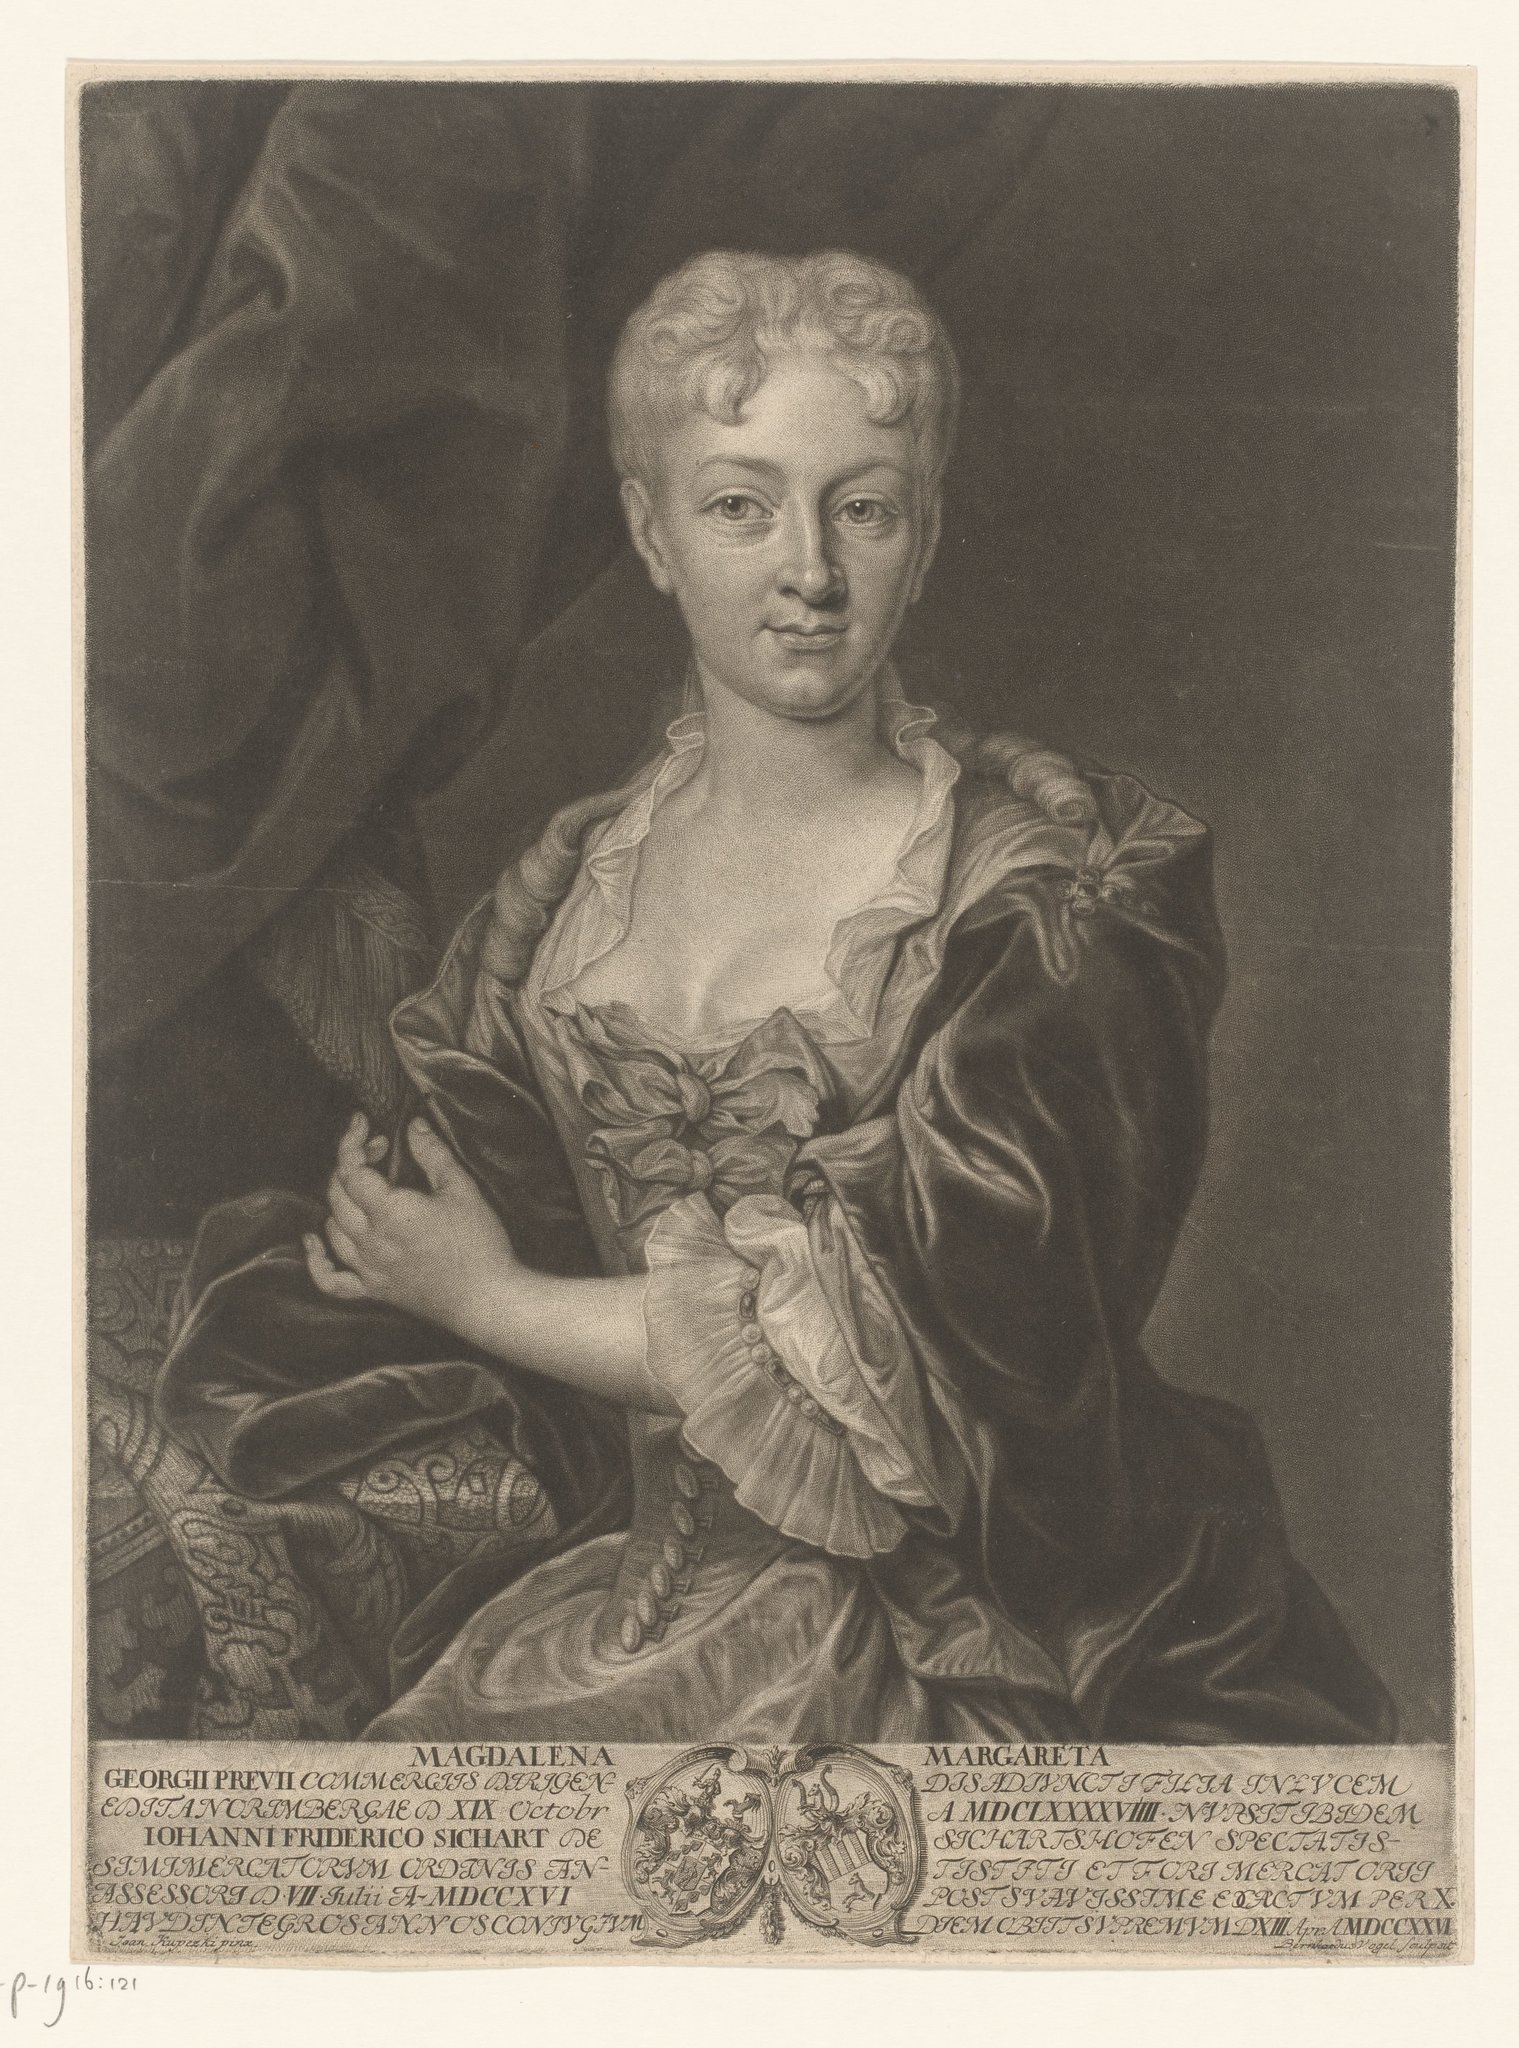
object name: print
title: Portret van Magdalena Margaretha Sichart von Sichartshofen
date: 1726-1737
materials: paper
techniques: mezzotint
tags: historical persons - bb - woman, armorial bearing, heraldry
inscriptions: collector's mark: Lugt 2228